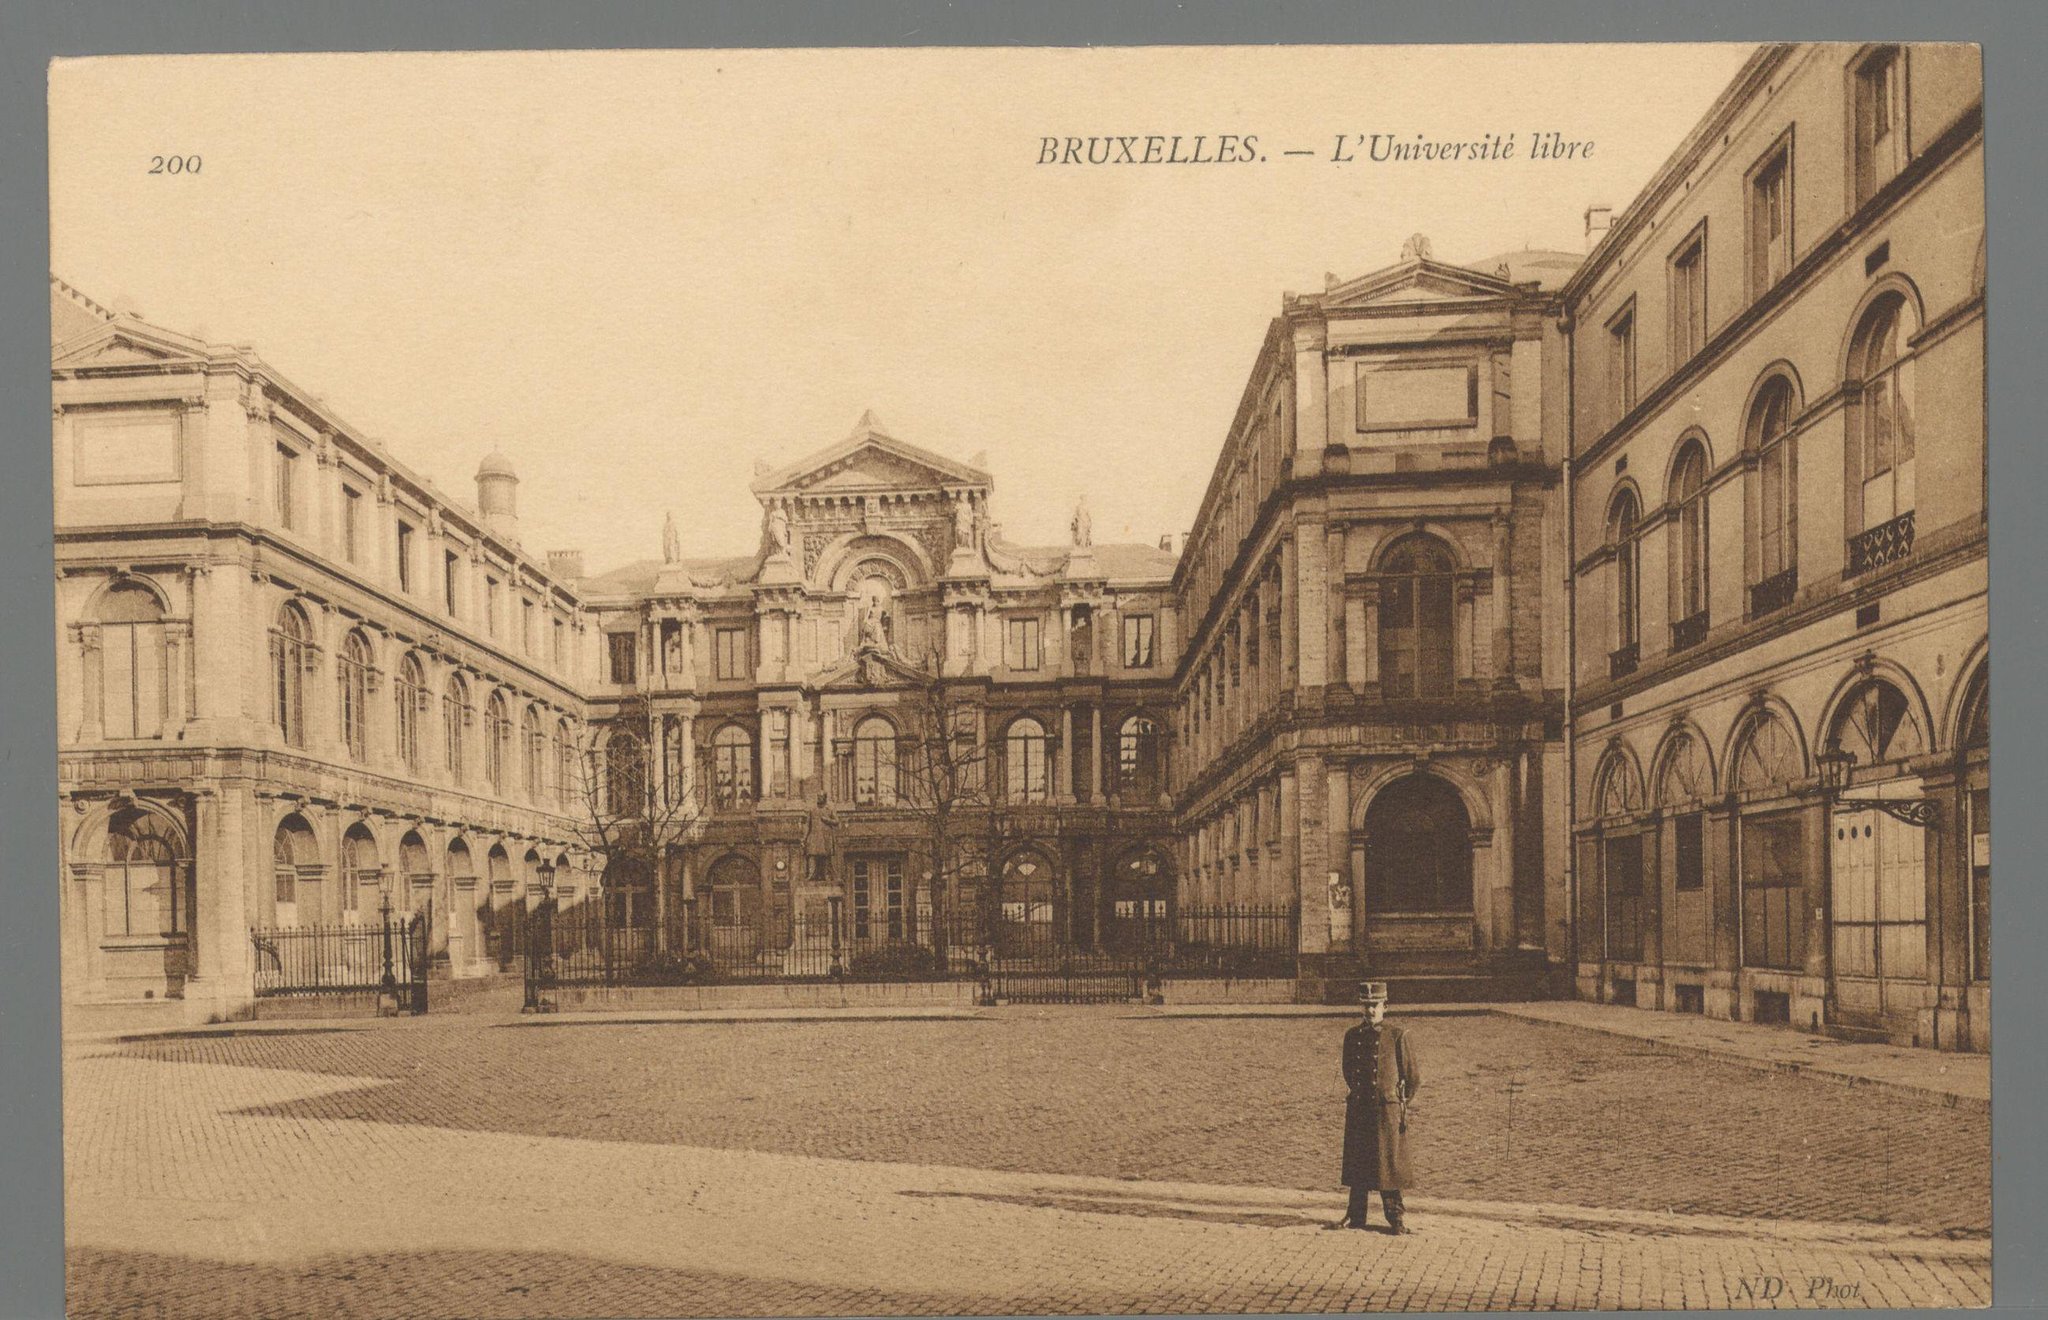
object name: photomechanical print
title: Bruxelles. L'Université libre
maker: Anonymous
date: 1906-1918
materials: cardboard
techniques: photograph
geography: paris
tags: square, place, circus, etc., university (+ building ~ education, tuition)